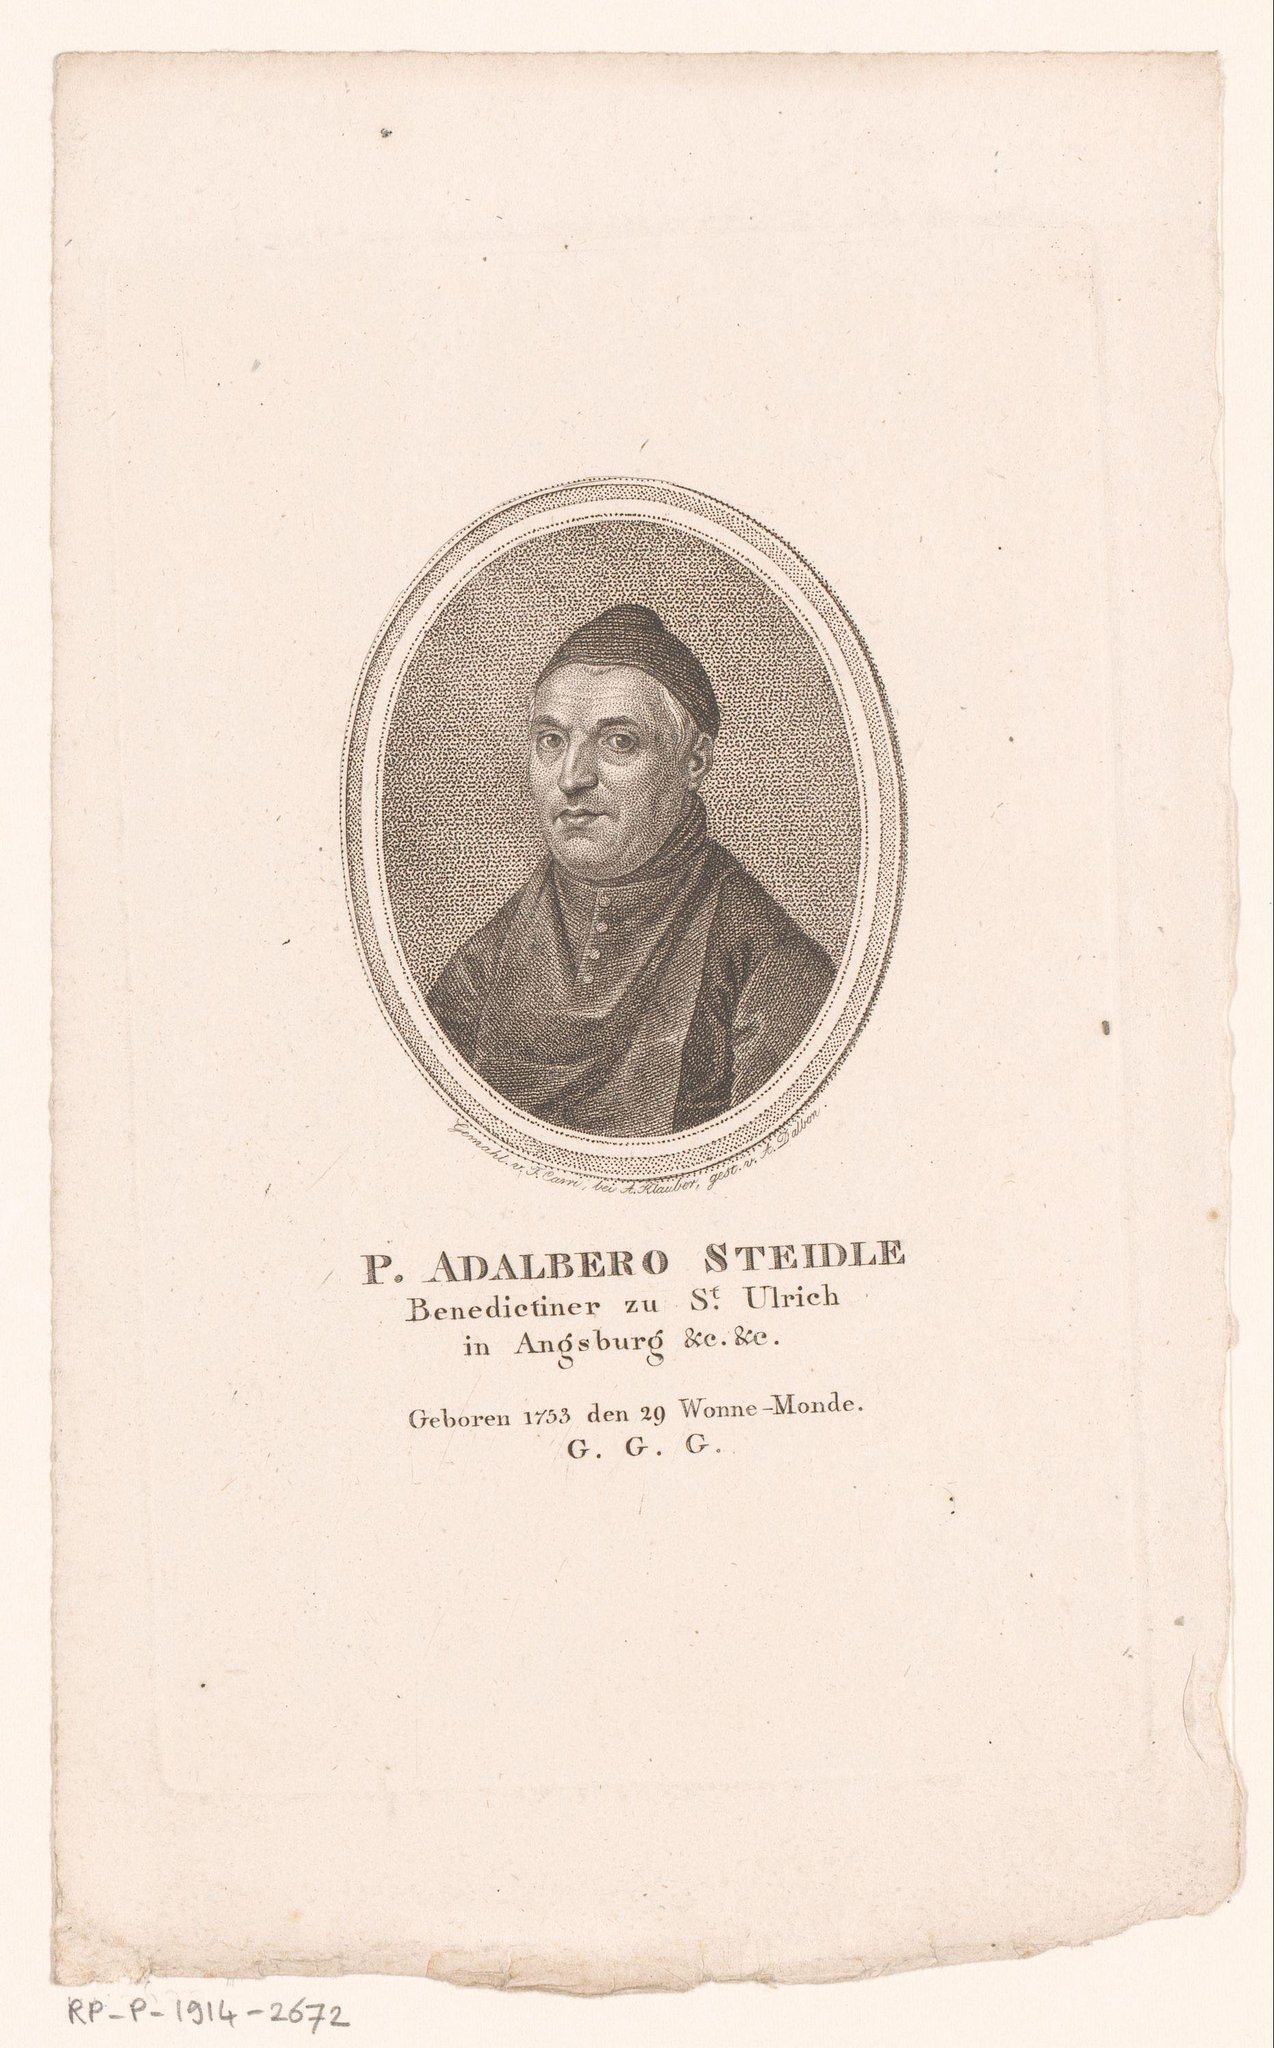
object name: print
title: Portret van P. Adabero Steidle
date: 1800-1899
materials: paper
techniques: etching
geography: france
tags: historical persons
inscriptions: collector's mark: Lugt 2228